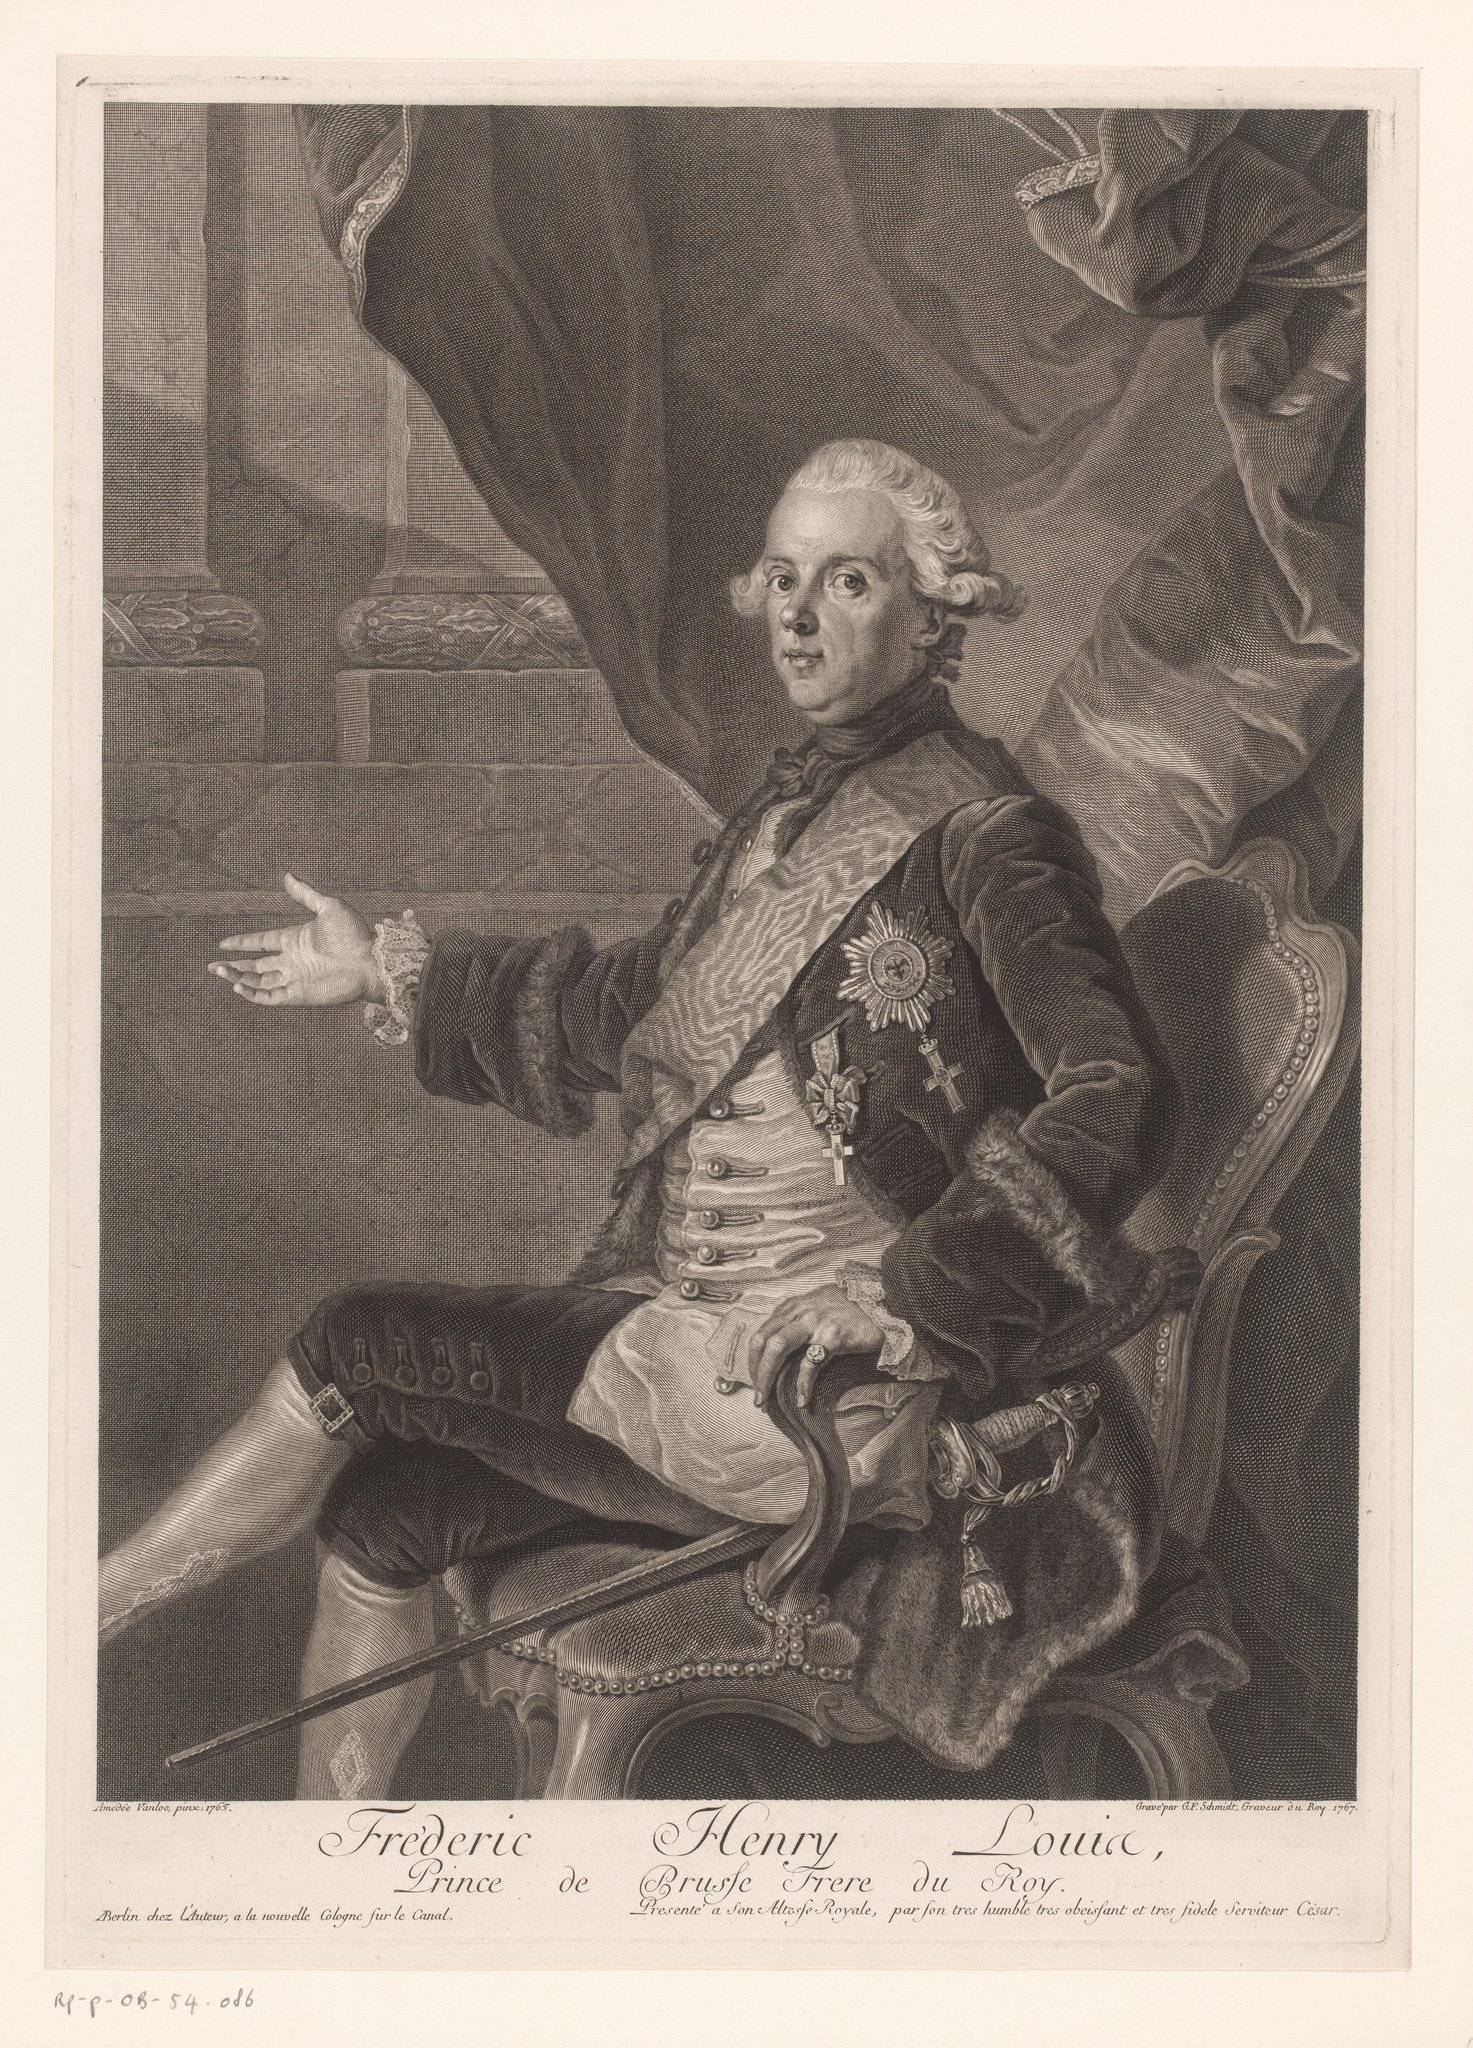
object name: print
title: Portret van prins Friedrich Heinrich Ludwig van Pruisen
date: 1767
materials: paper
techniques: engraving, etching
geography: berlin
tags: berlin, friedrich heinrich ludwig van pruisen, historical persons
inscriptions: date